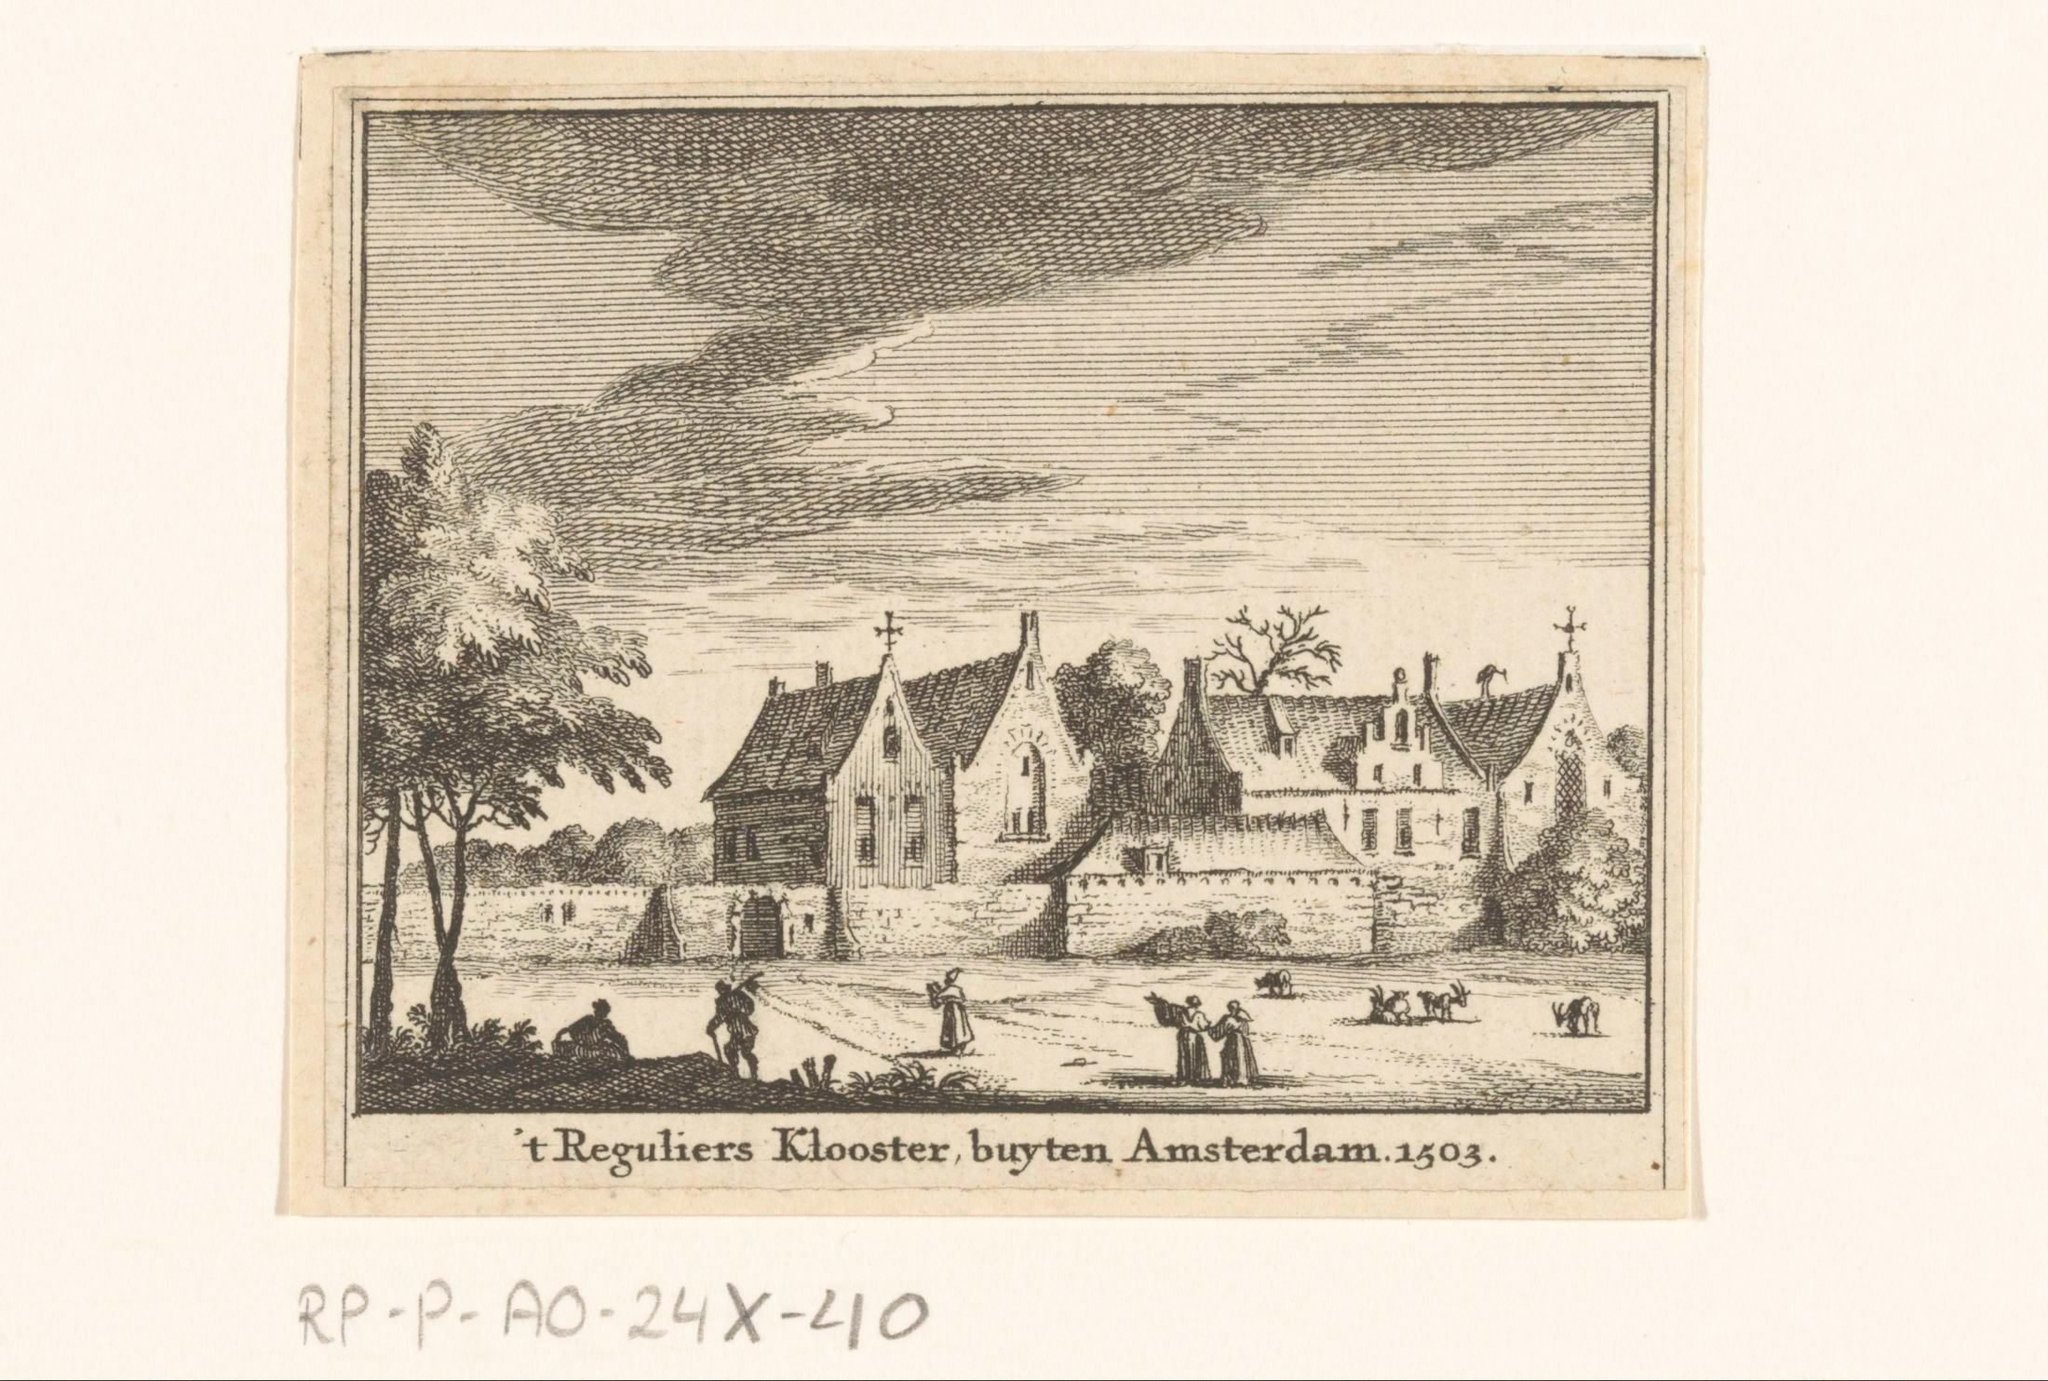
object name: book illustration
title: Gezicht op het Reguliersklooster buiten Amsterdam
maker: jan goeree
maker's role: draughtsman, print maker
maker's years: 1670-1731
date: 1723-1738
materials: paper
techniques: engraving, etching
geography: amsterdam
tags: abbey, monastery, convent ~ roman catholic church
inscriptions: collector's mark: Lugt 2233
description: Prent ook gebruikt in: Willink, Daniël. Amsterdamsche Buitensingel nevens de omleggende dorpen, opgeheldert door aanteekeningen over veele voornaame geschiedeniszen: met afbeeldingen (…) / Daniël Willinks Amsterdamsche Buitensingel. Amsterdam: Andries van Damme, 1723. En in: Willink, Daniël. Amsterdamsche Buitensingel nevens de omleggende dorpen, opgeheldert door aanteekeningen over veele voornaame geschiedenissen: met afbeeldingen (…) / Daniël Willinks Amsterdamsche Buitensingel. Amsterdam: Arend van Huyssteen, 1738. Zie ook RP-P-1911-3006 en RP-P-AO-27-8-1.